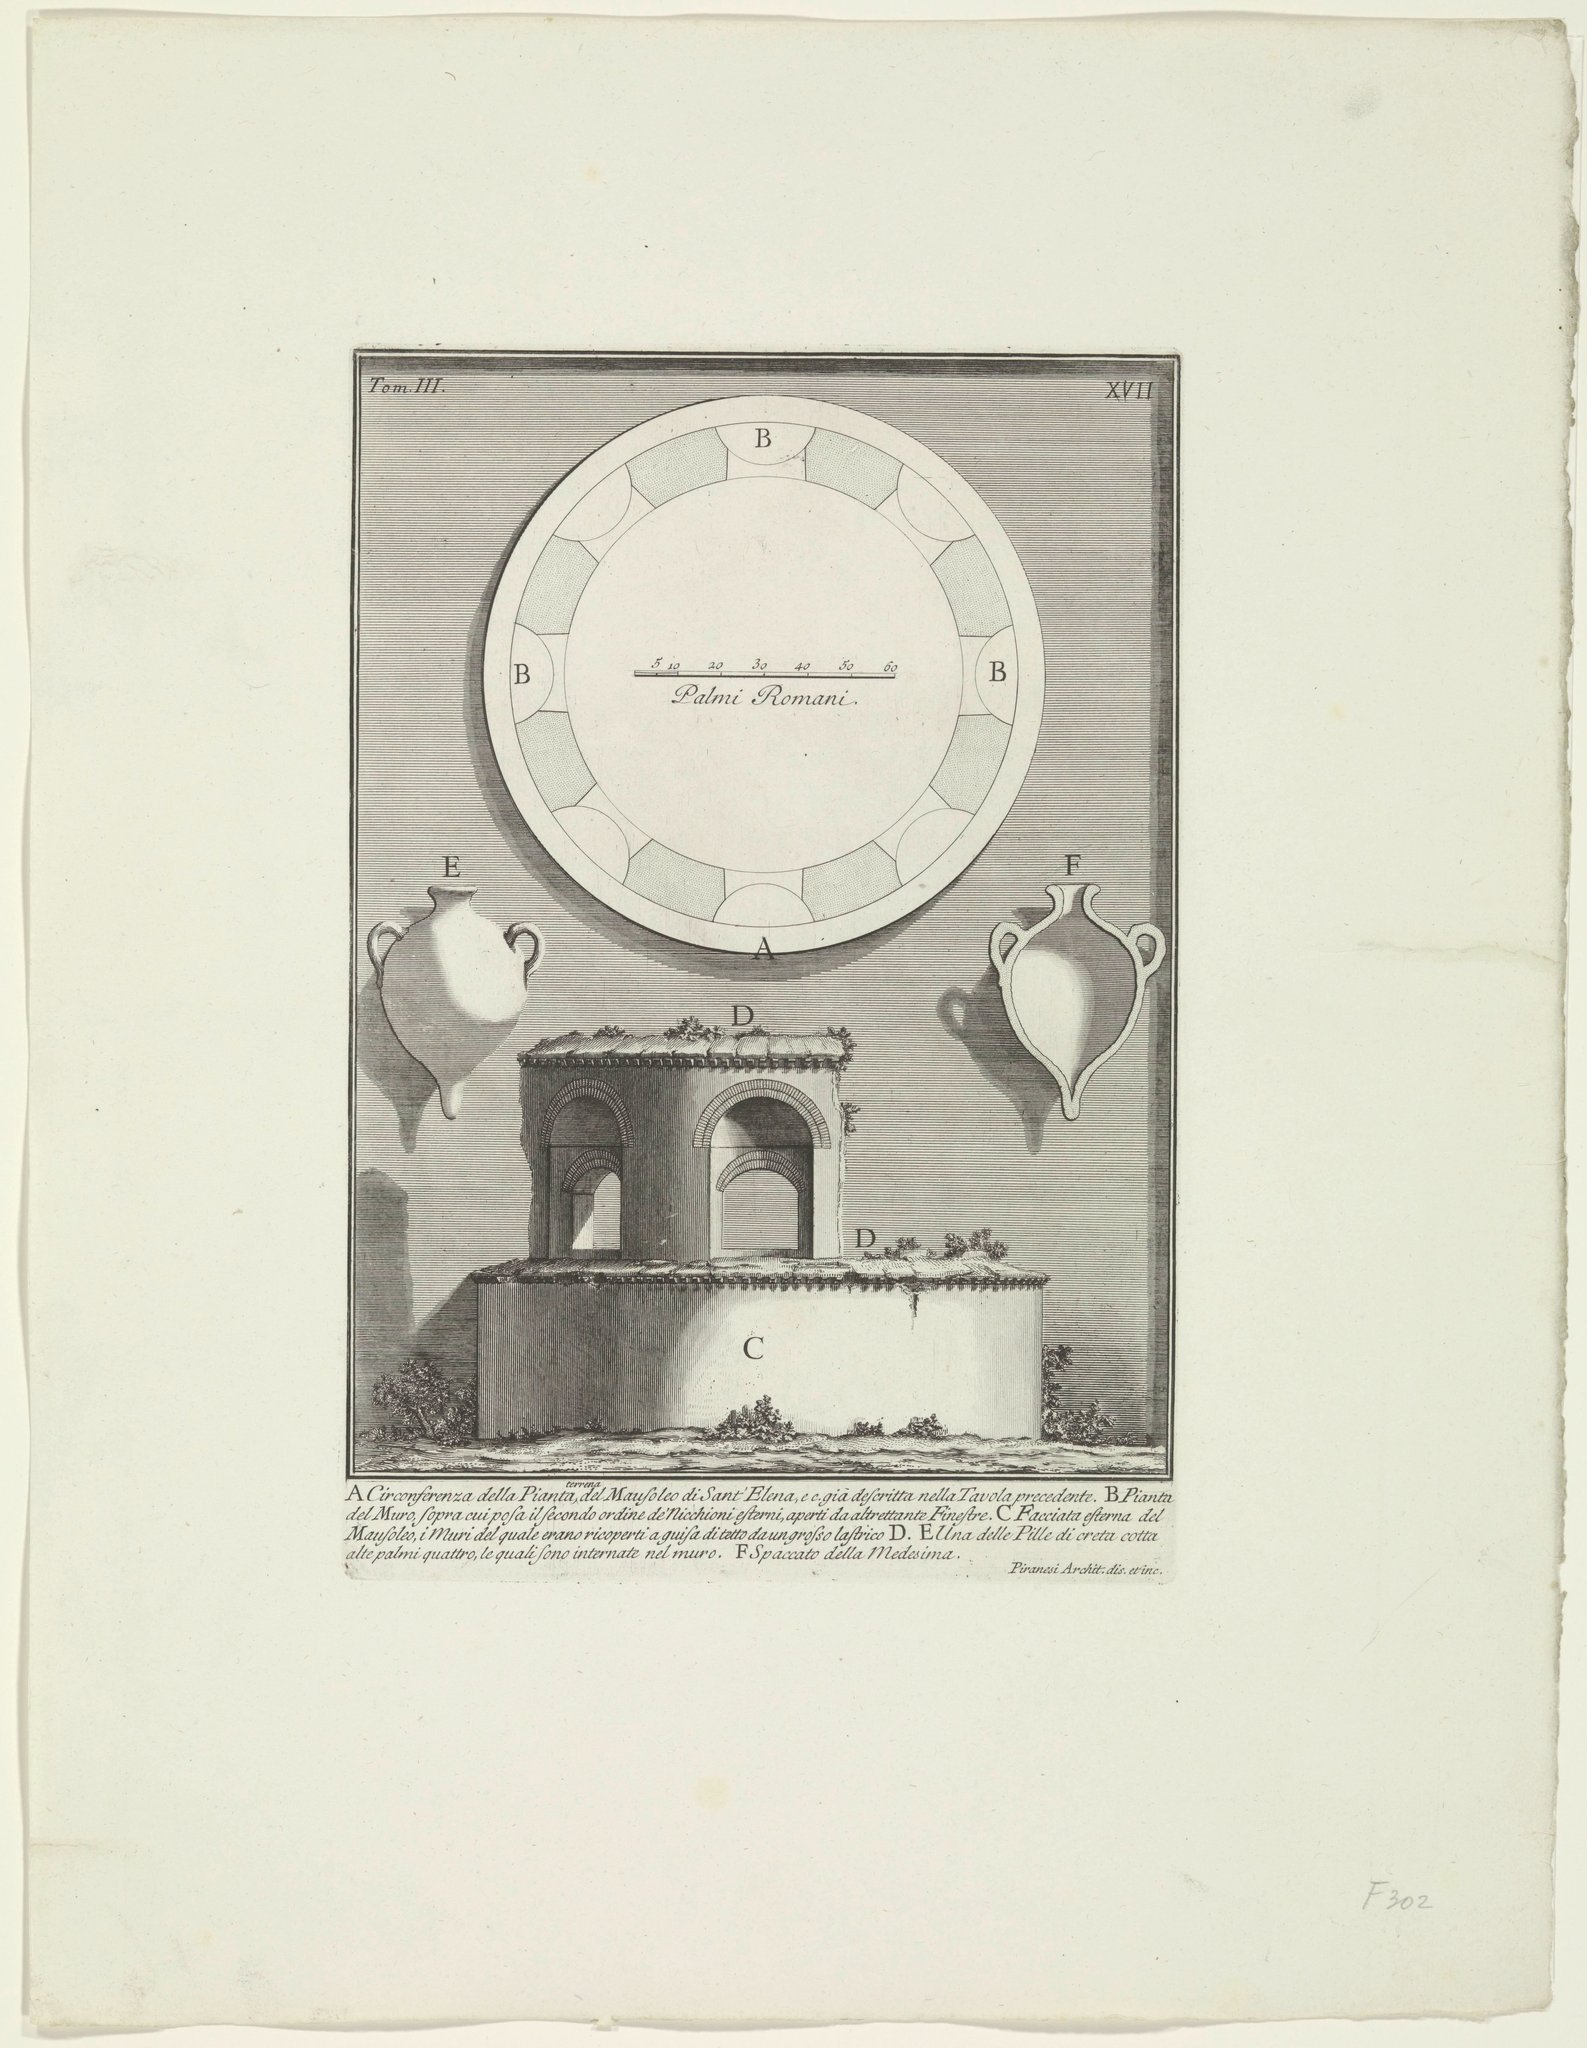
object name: print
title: Mausoleum van Helena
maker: giovanni battista piranesi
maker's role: designer, draughtsman, print maker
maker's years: 1720-1778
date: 1756-1757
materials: paper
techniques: etching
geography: rome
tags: ruin of a building ~ architecture, grave, tomb, mausoleum, container of stone: stone vase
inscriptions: collector's mark: Lugt 2228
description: Deze prent maakt deel uit van de serie 'Le Antichità Romane'. Piranesi deed meer dan acht jaar voorstudie voor deze 250 platen tellende serie die in vier volumes werd uitgegeven. Hij produceerde de prenten tussen ca. 1756 en 1757. De serie bevat ook prenten door of naar andere prentmakers, onder wie Francesco Bianchini en Girolamo Rossi.